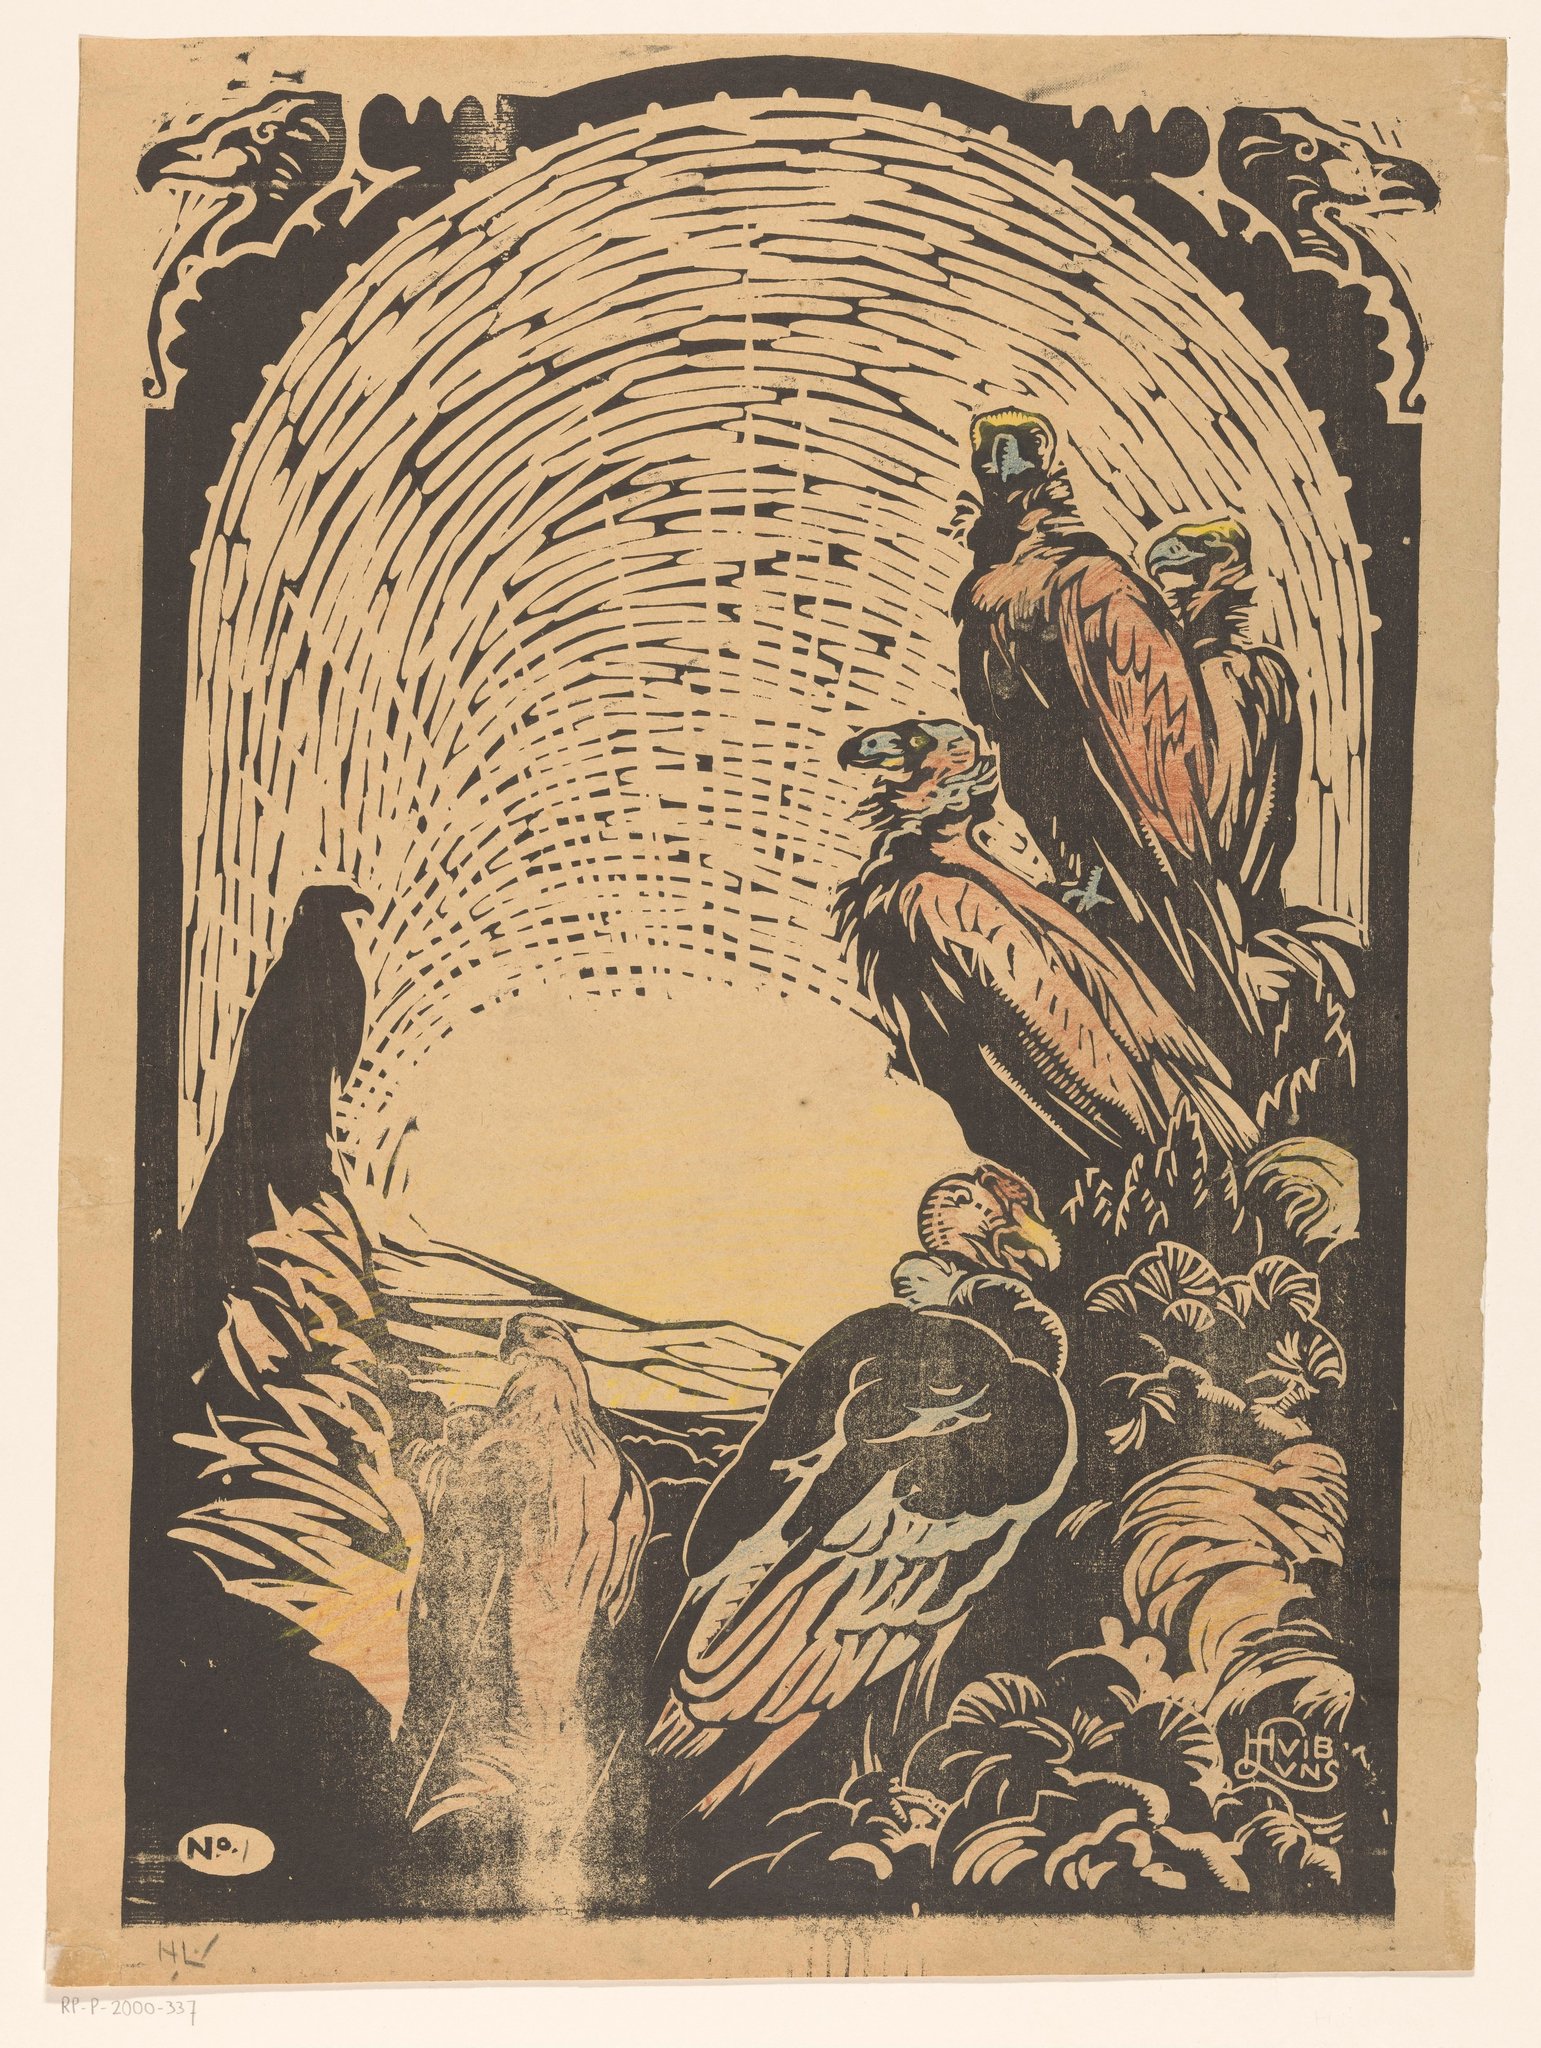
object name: print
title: De Condors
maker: huib luns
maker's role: draughtsman, print maker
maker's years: 1881-1942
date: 1915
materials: paper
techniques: woodcut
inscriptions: signature and date: ‘Huib Luns 1918’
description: Zes Condors, zittend op rotsen op de voorgrond. Door een boogvormige rotsopening ondergaande zon te zien.